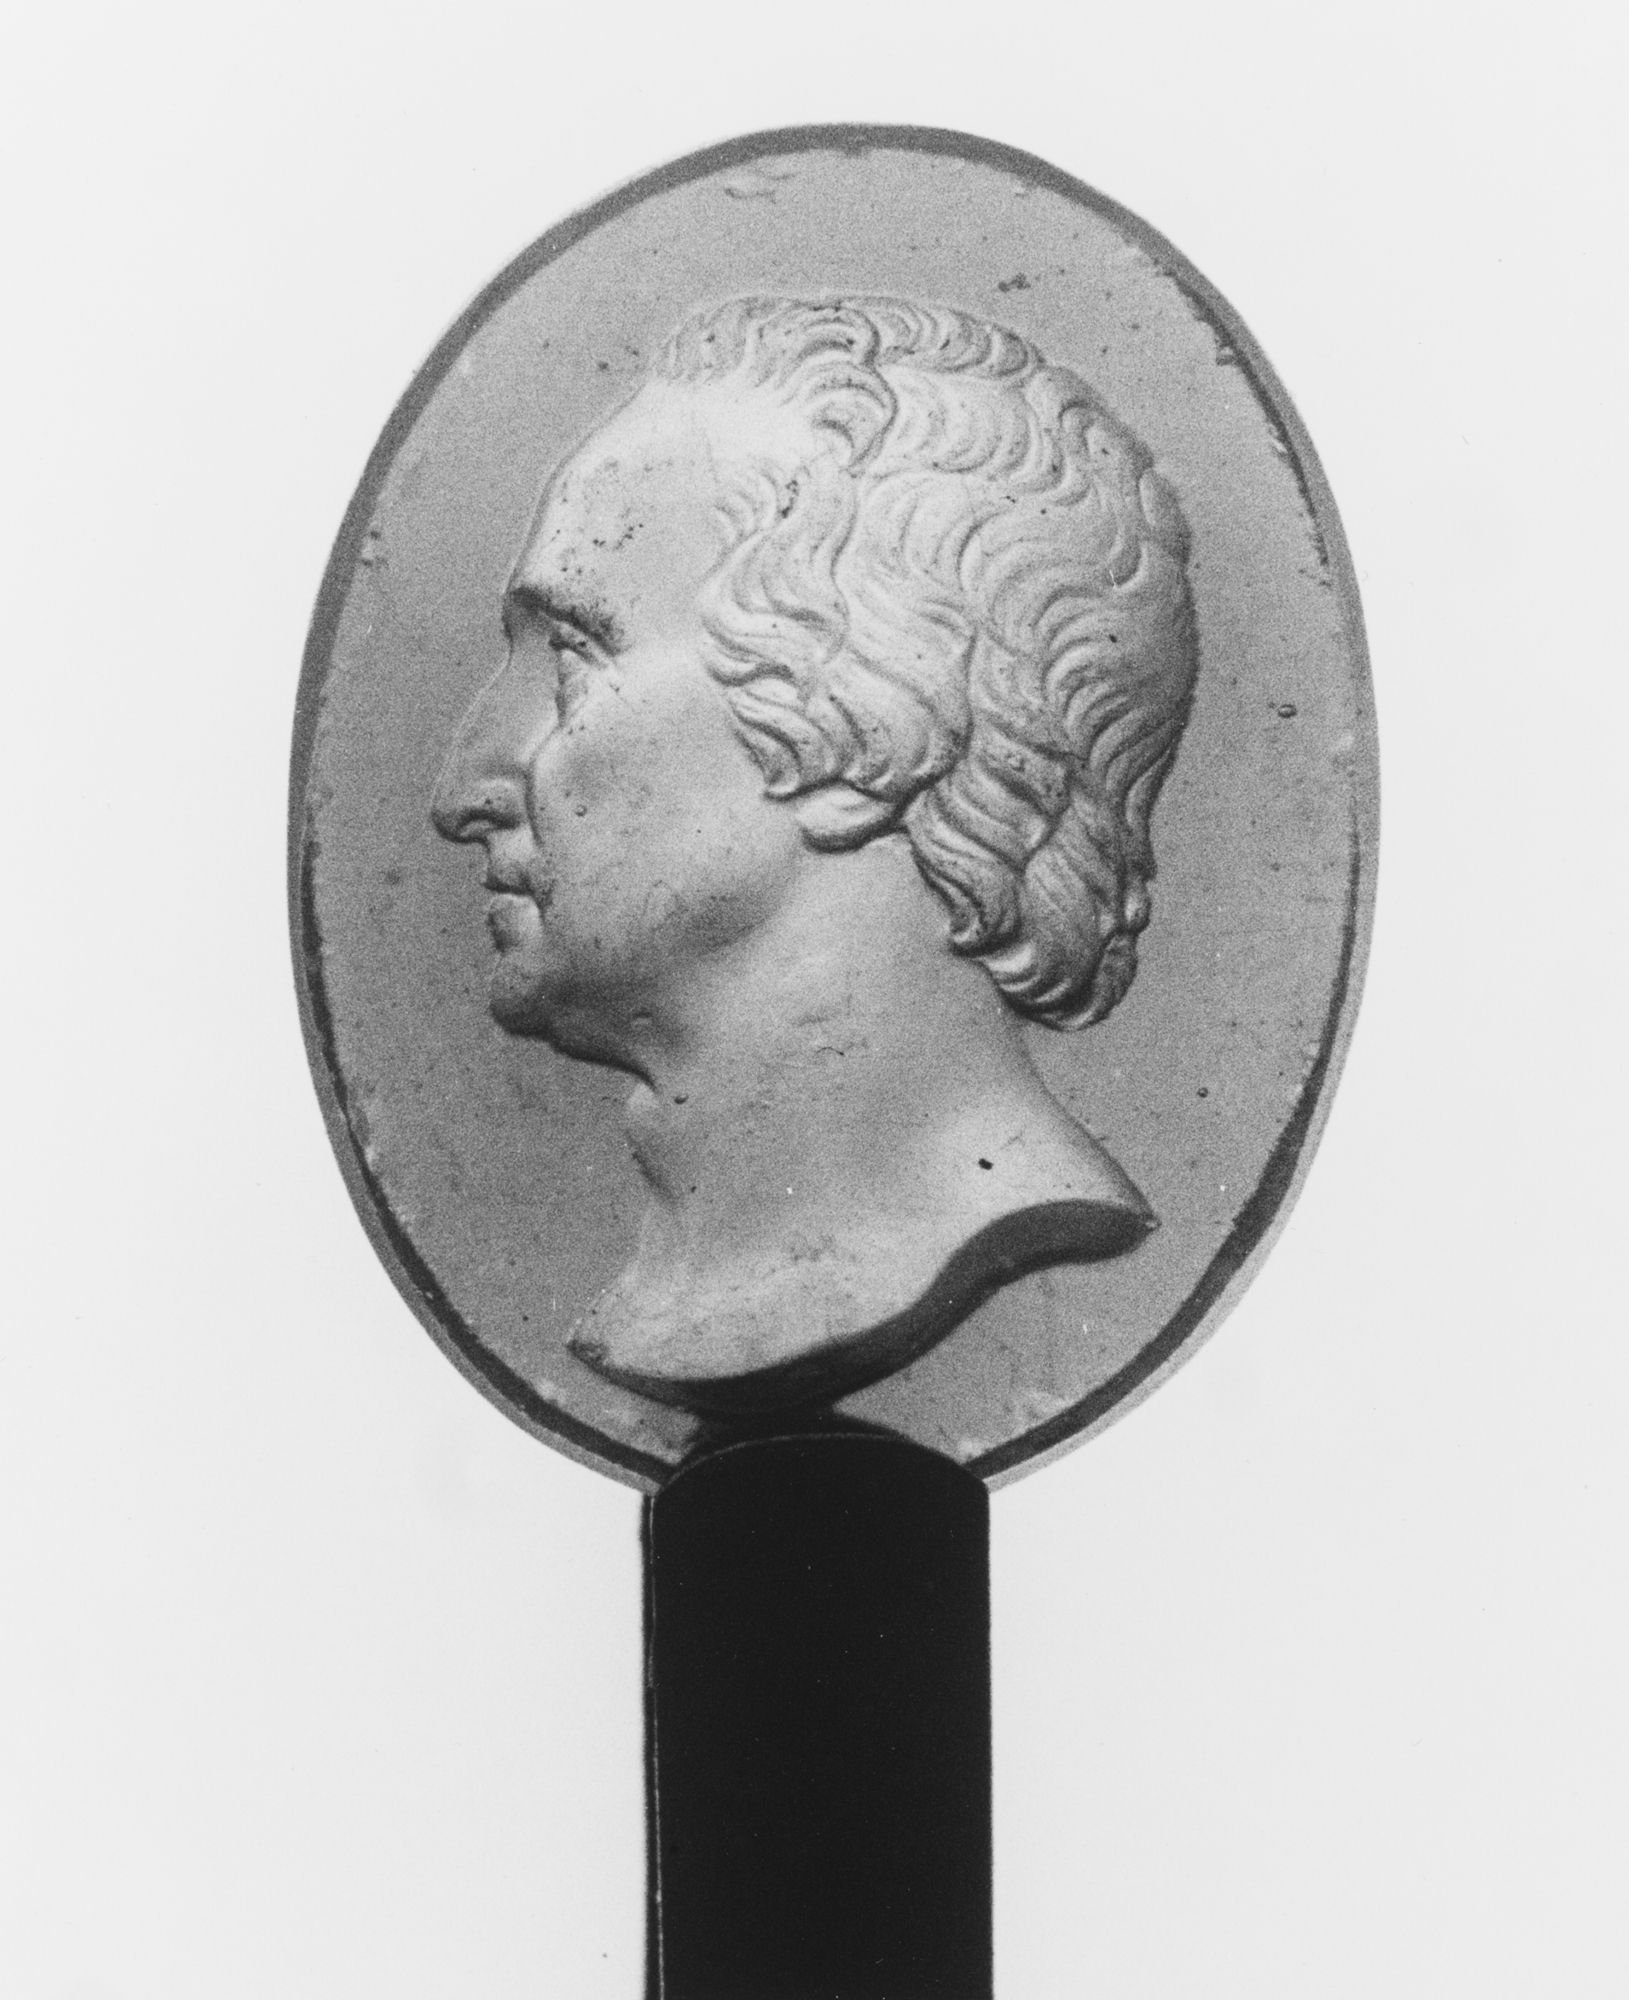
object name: medallion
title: George Washington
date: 1776-1830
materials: glass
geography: england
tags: george washington,men,portraits,profiles